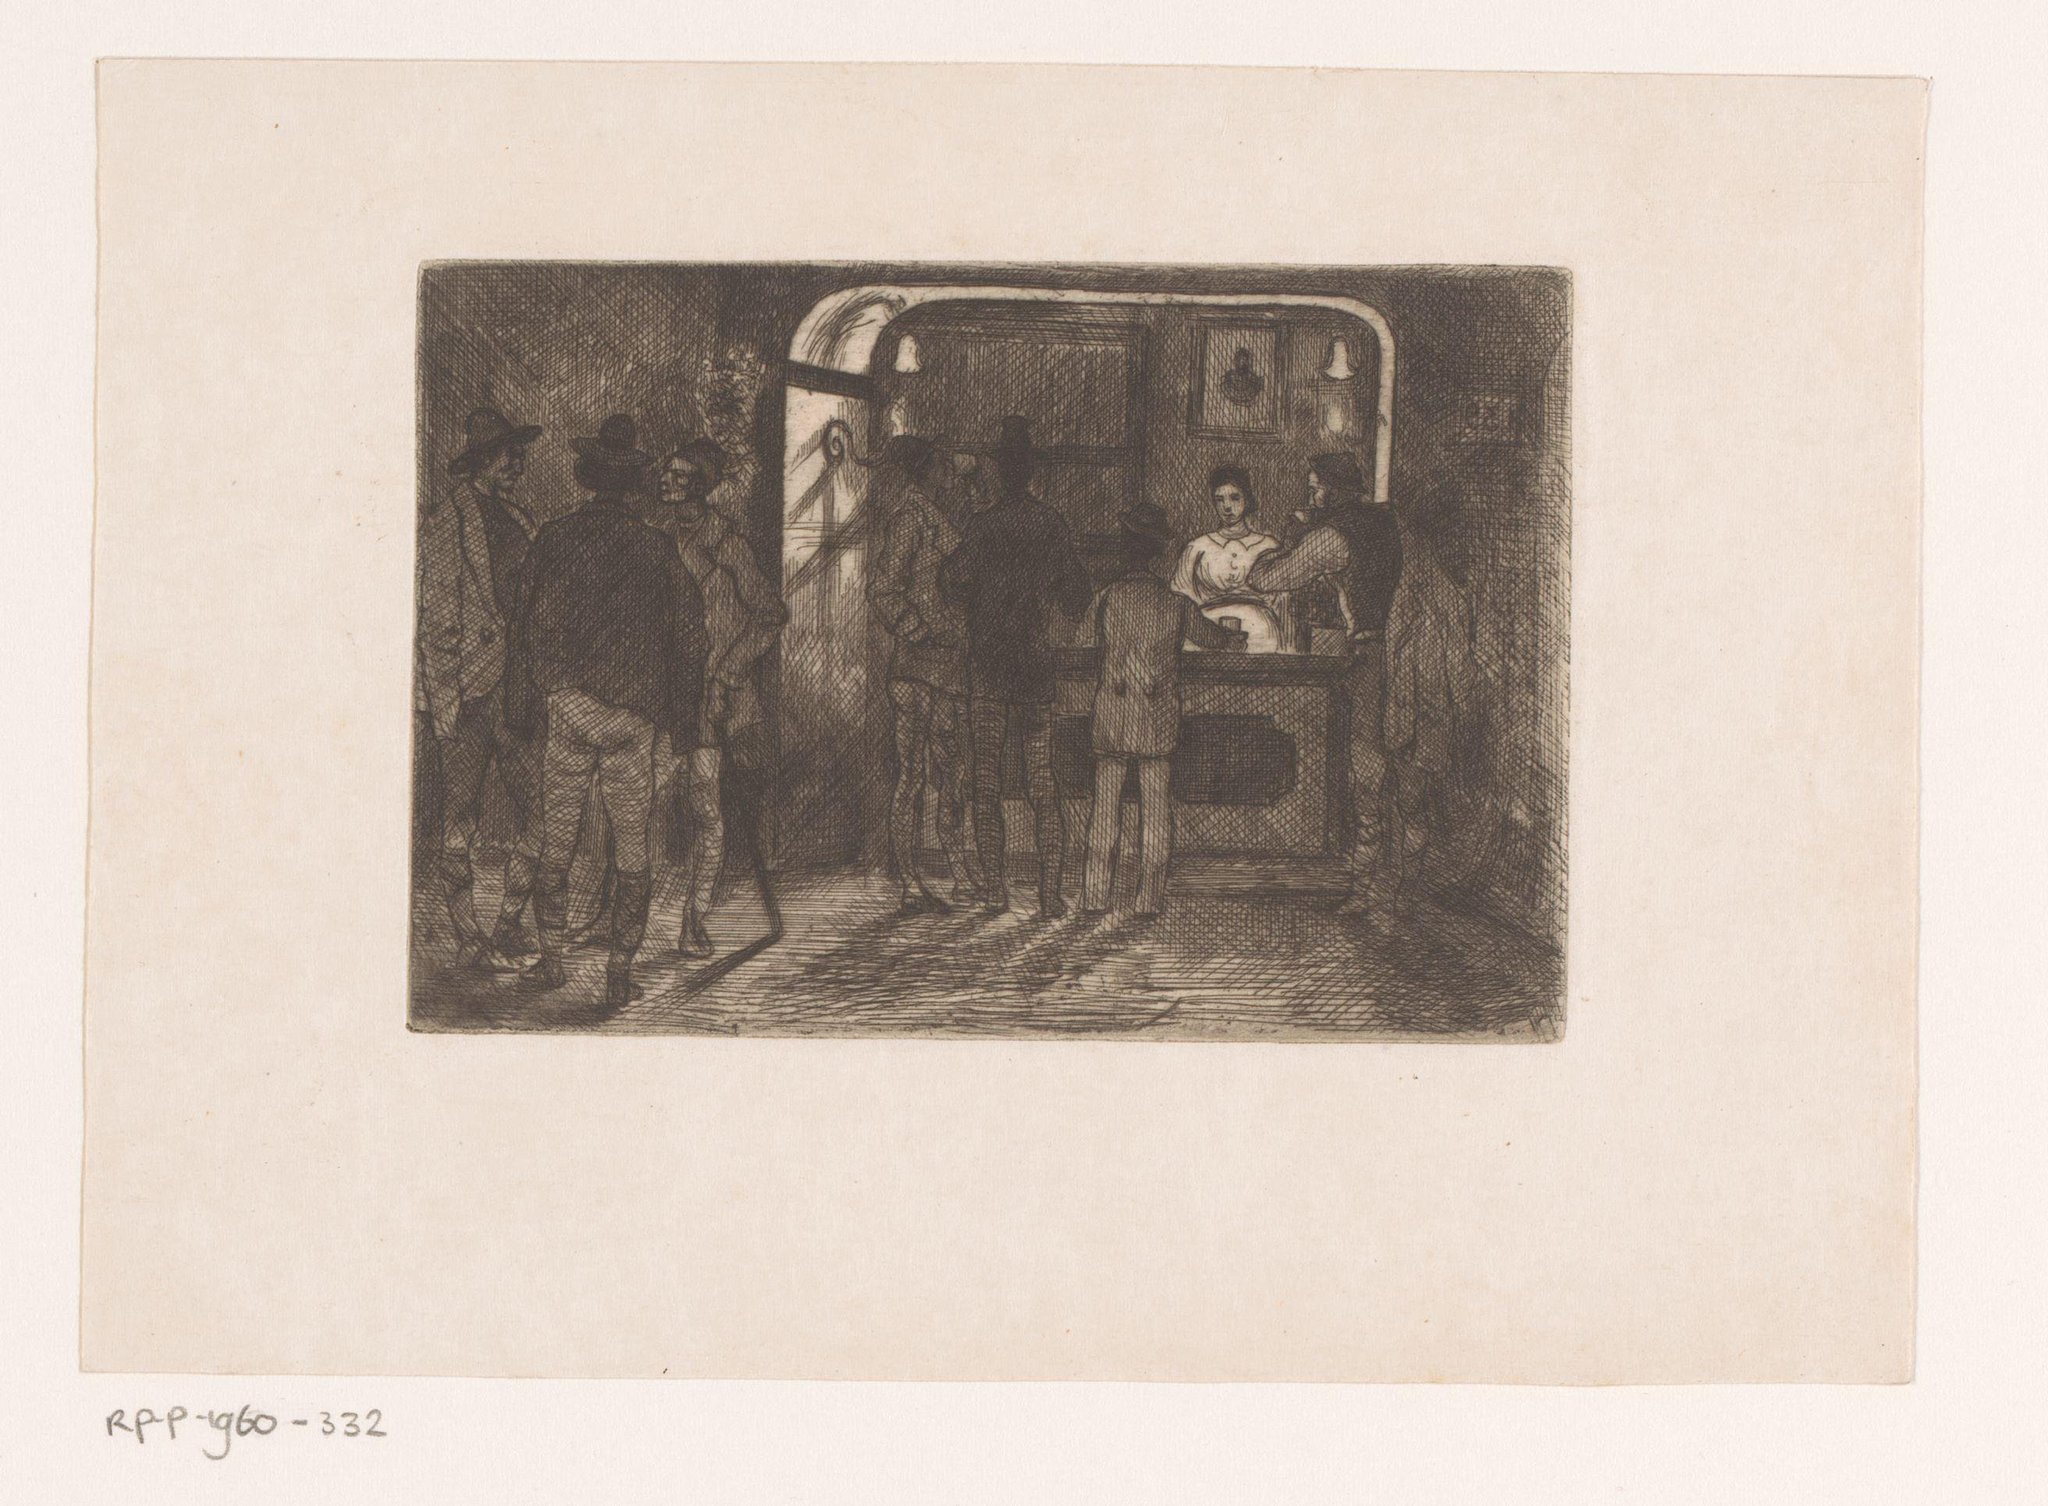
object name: print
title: Zeven mannen in een bar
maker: xavier mellery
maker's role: print maker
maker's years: 1845-1921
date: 1855-1913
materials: paper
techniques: etching, intaglio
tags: adult woman, adult man (+ seven persons), inn, coffee-house, public house, etc., drinking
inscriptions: collector's mark: Lugt 2228